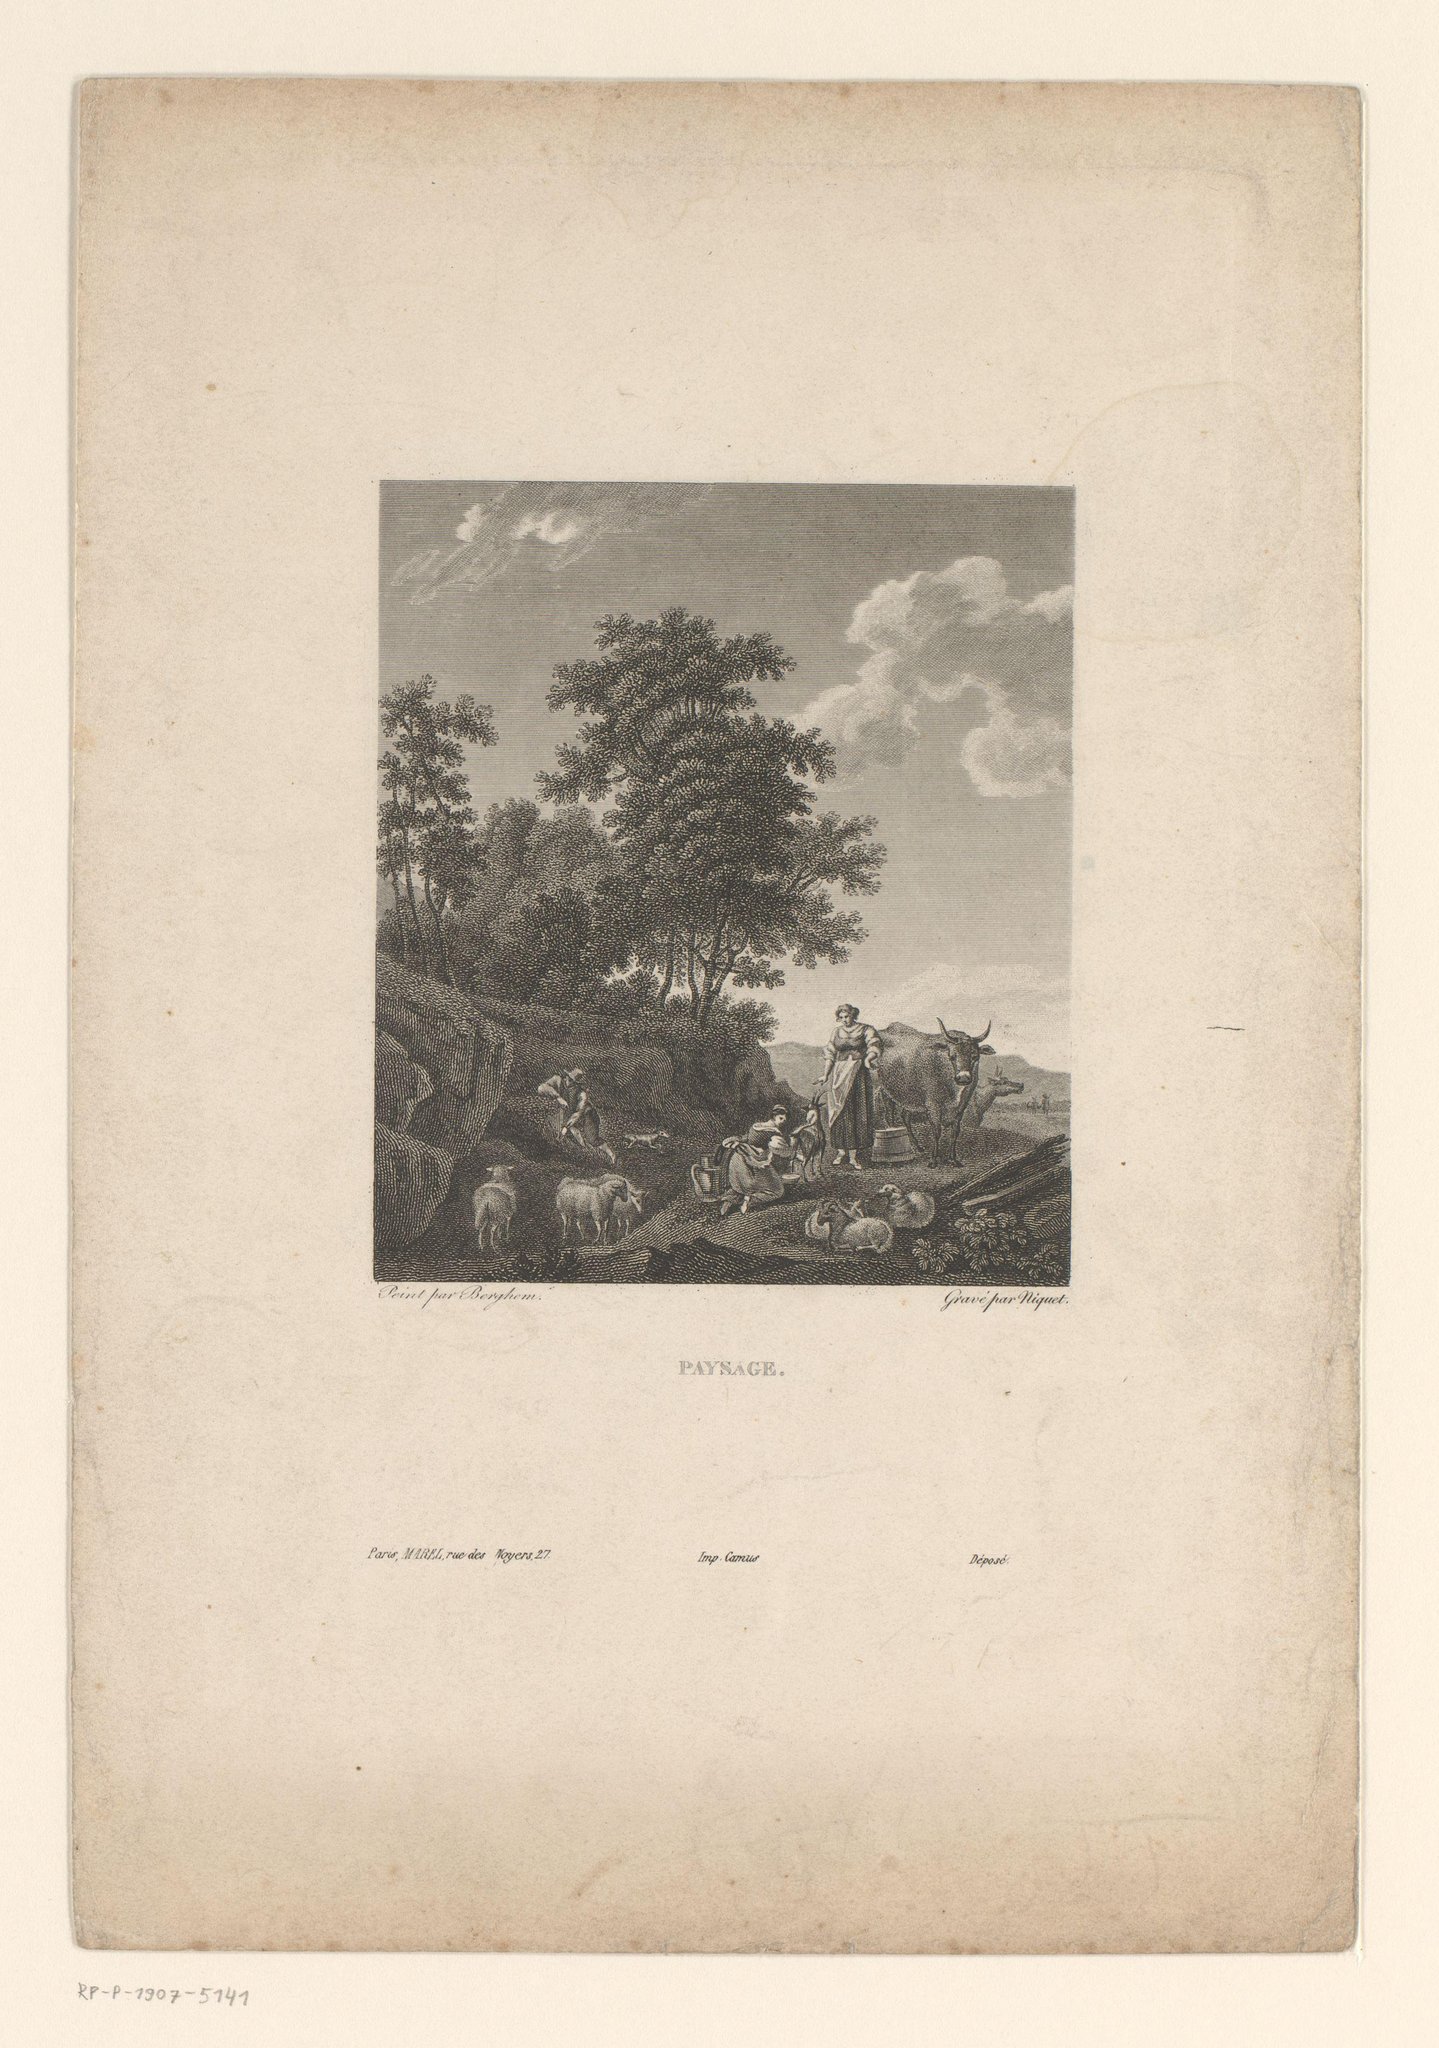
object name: print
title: Paysage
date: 1770-1831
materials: paper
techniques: etching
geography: paris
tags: herding, herdsman, herdswoman, shepherd, shepherdess, cowherd, etc., landscapes (+ landscape with figures, staffage), herd, flock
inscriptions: collector's mark: Lugt 2228, : ‘Déposé’